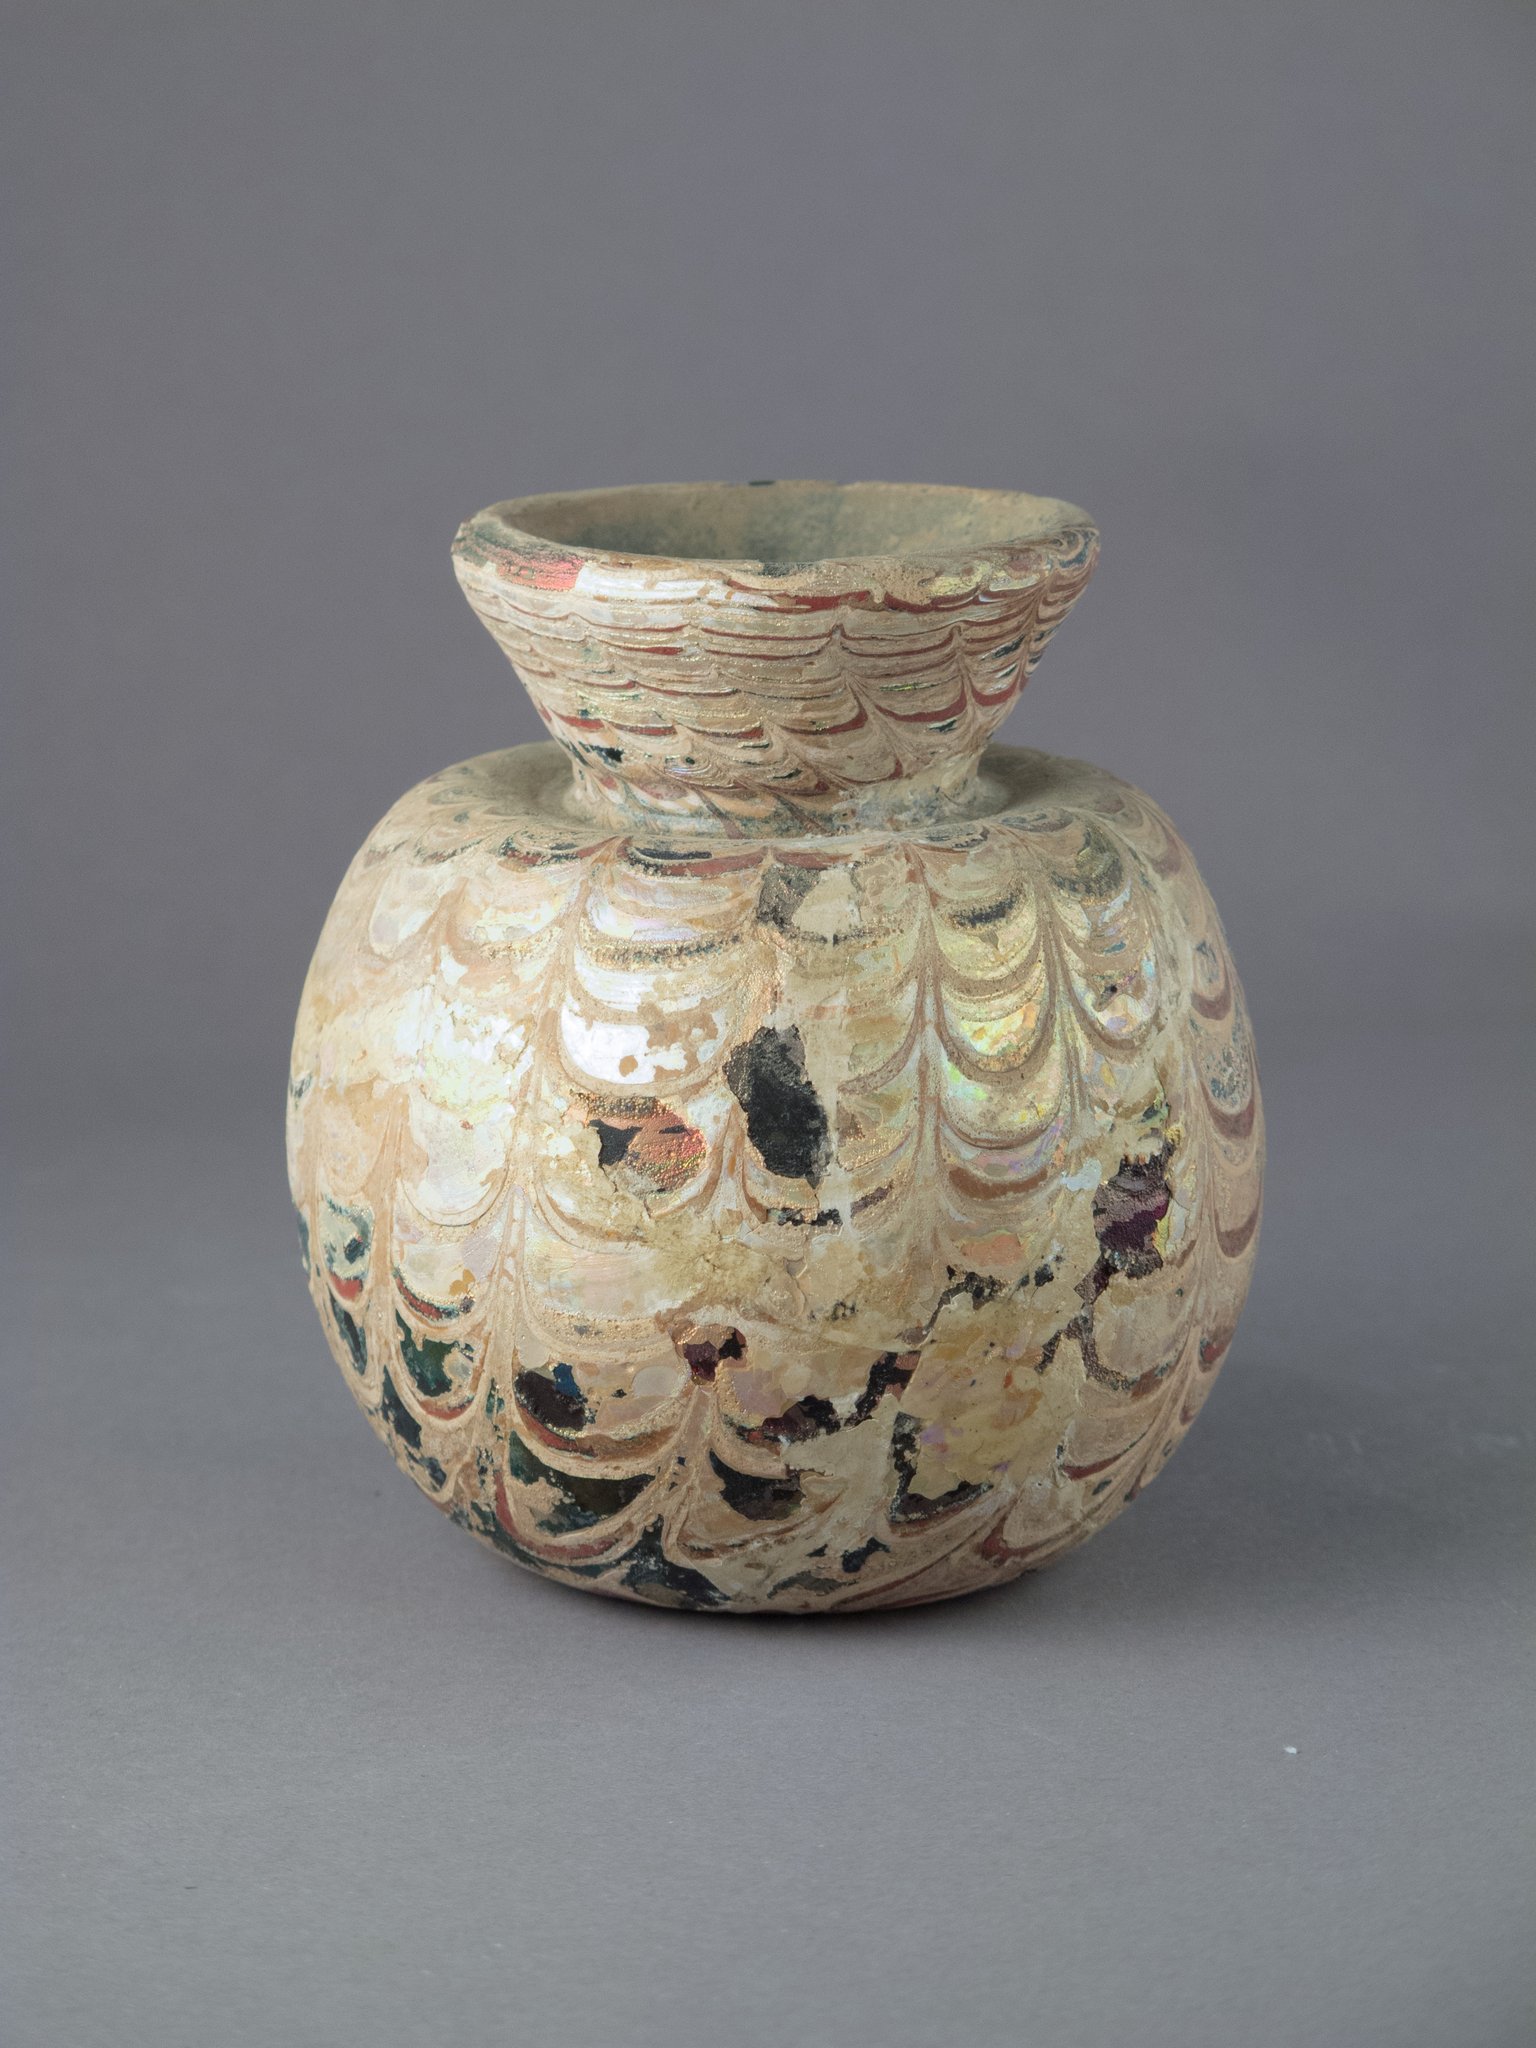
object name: jar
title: Glass jar with marvered trails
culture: roman, syro-palestinian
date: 401-500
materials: glass